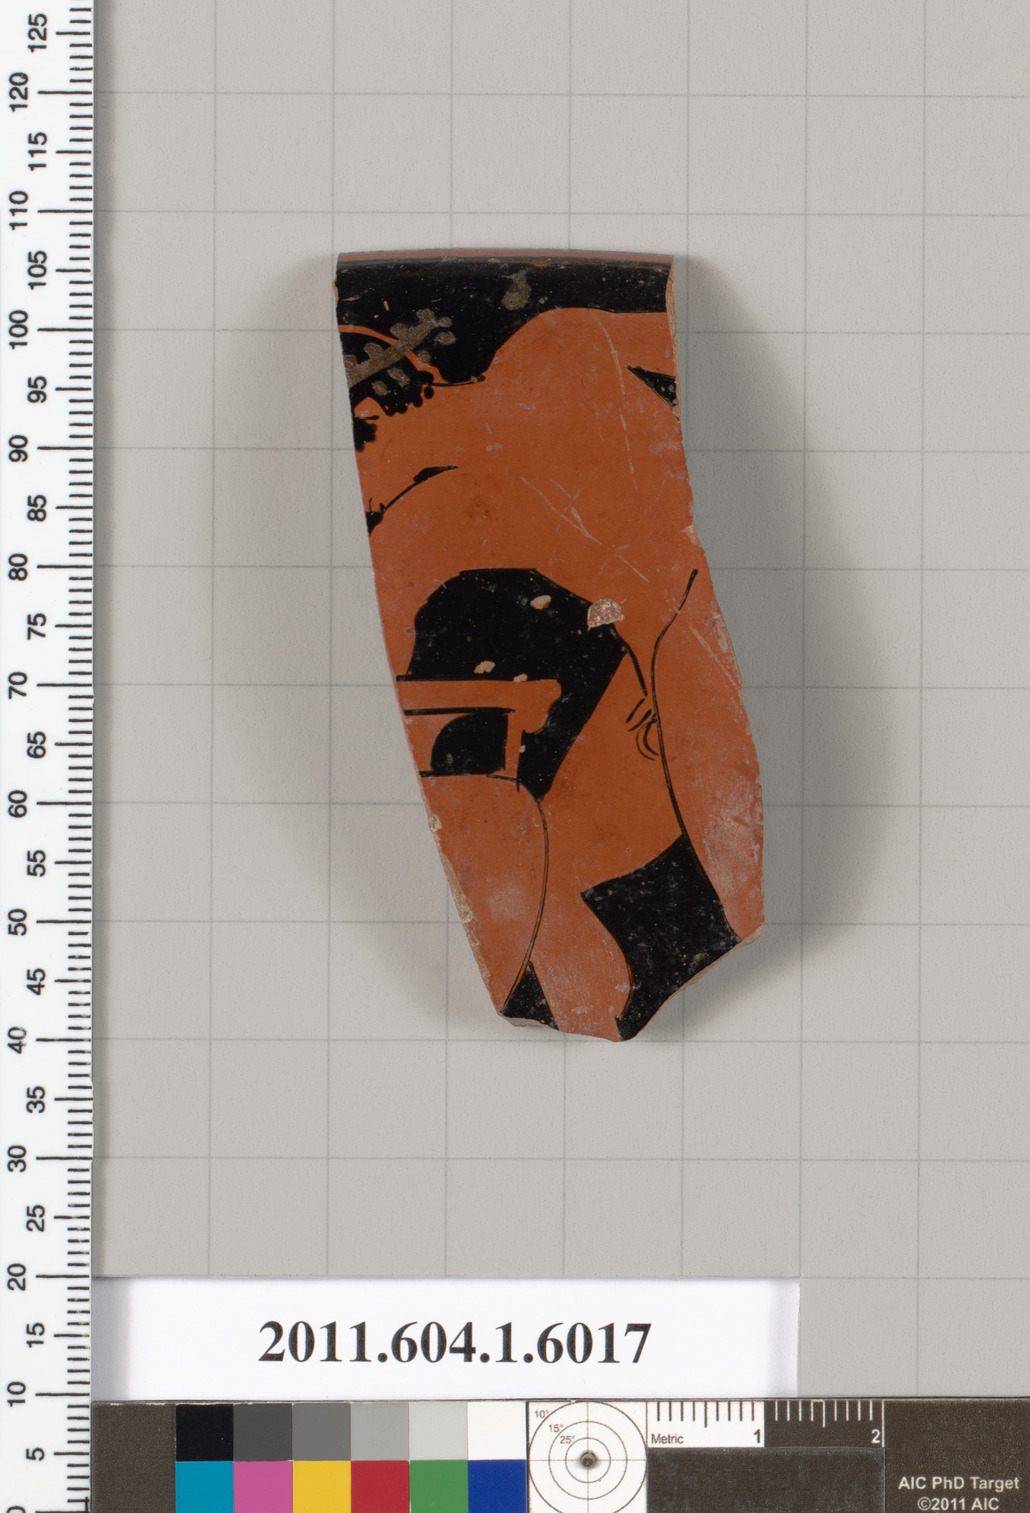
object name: kylix fragment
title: Terracotta rim fragment of a kylix (drinking cup)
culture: greek, attic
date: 510-500 BCE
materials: terracotta